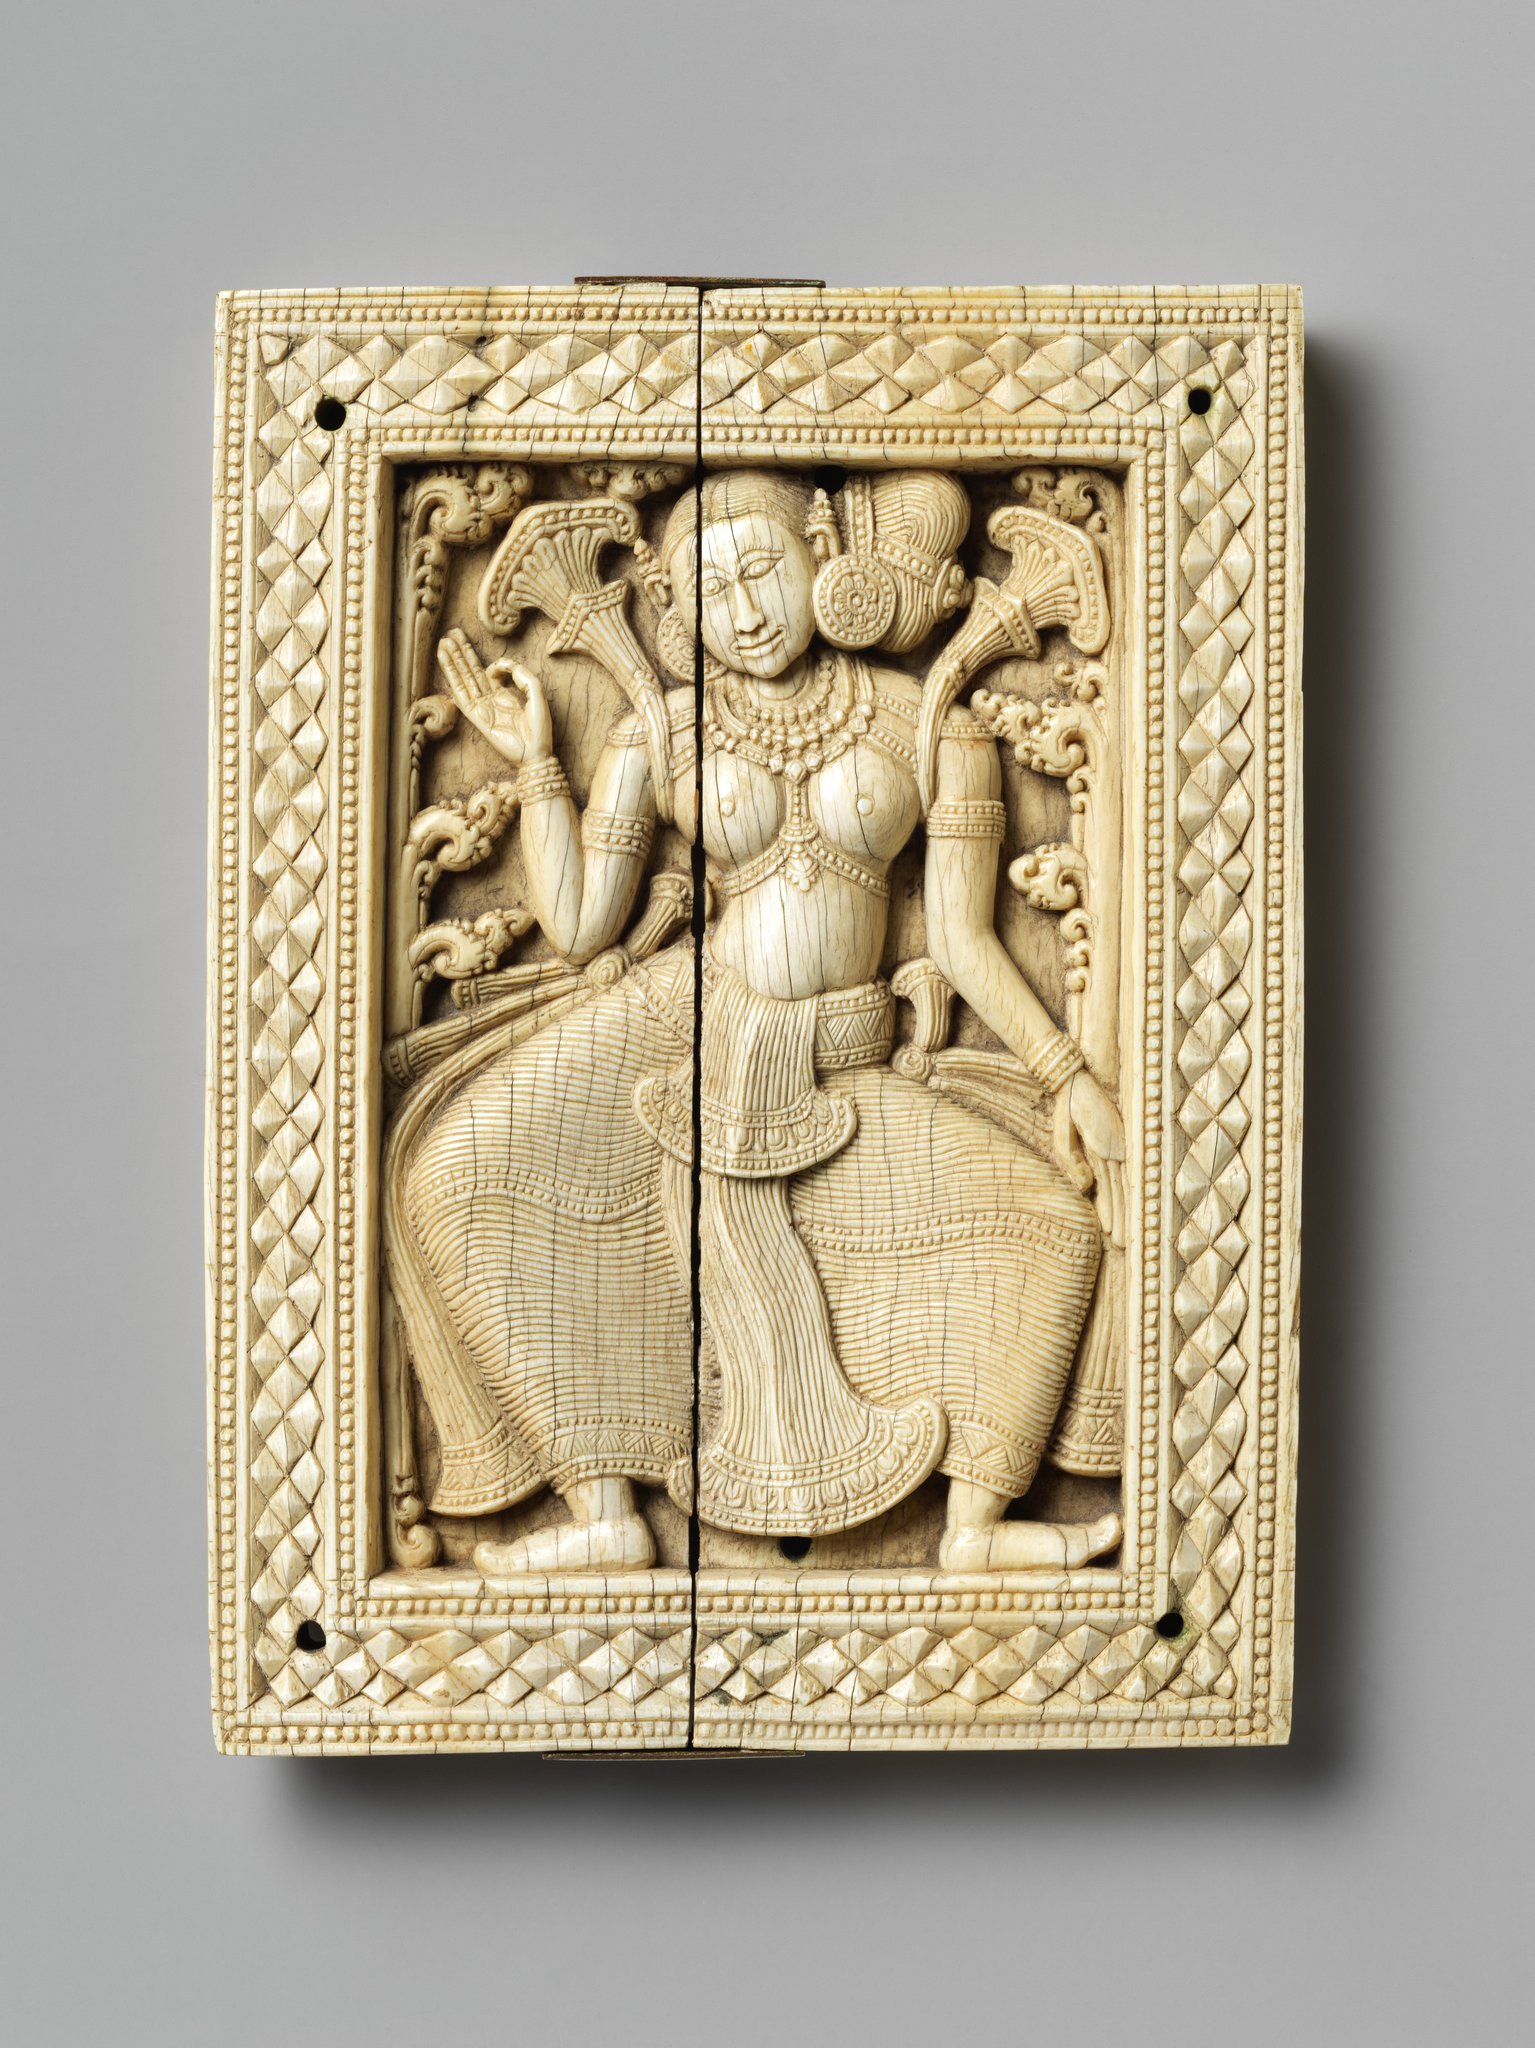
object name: panel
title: Temple Dancer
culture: sri lankan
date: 1701-1800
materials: ivory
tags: women,dancers